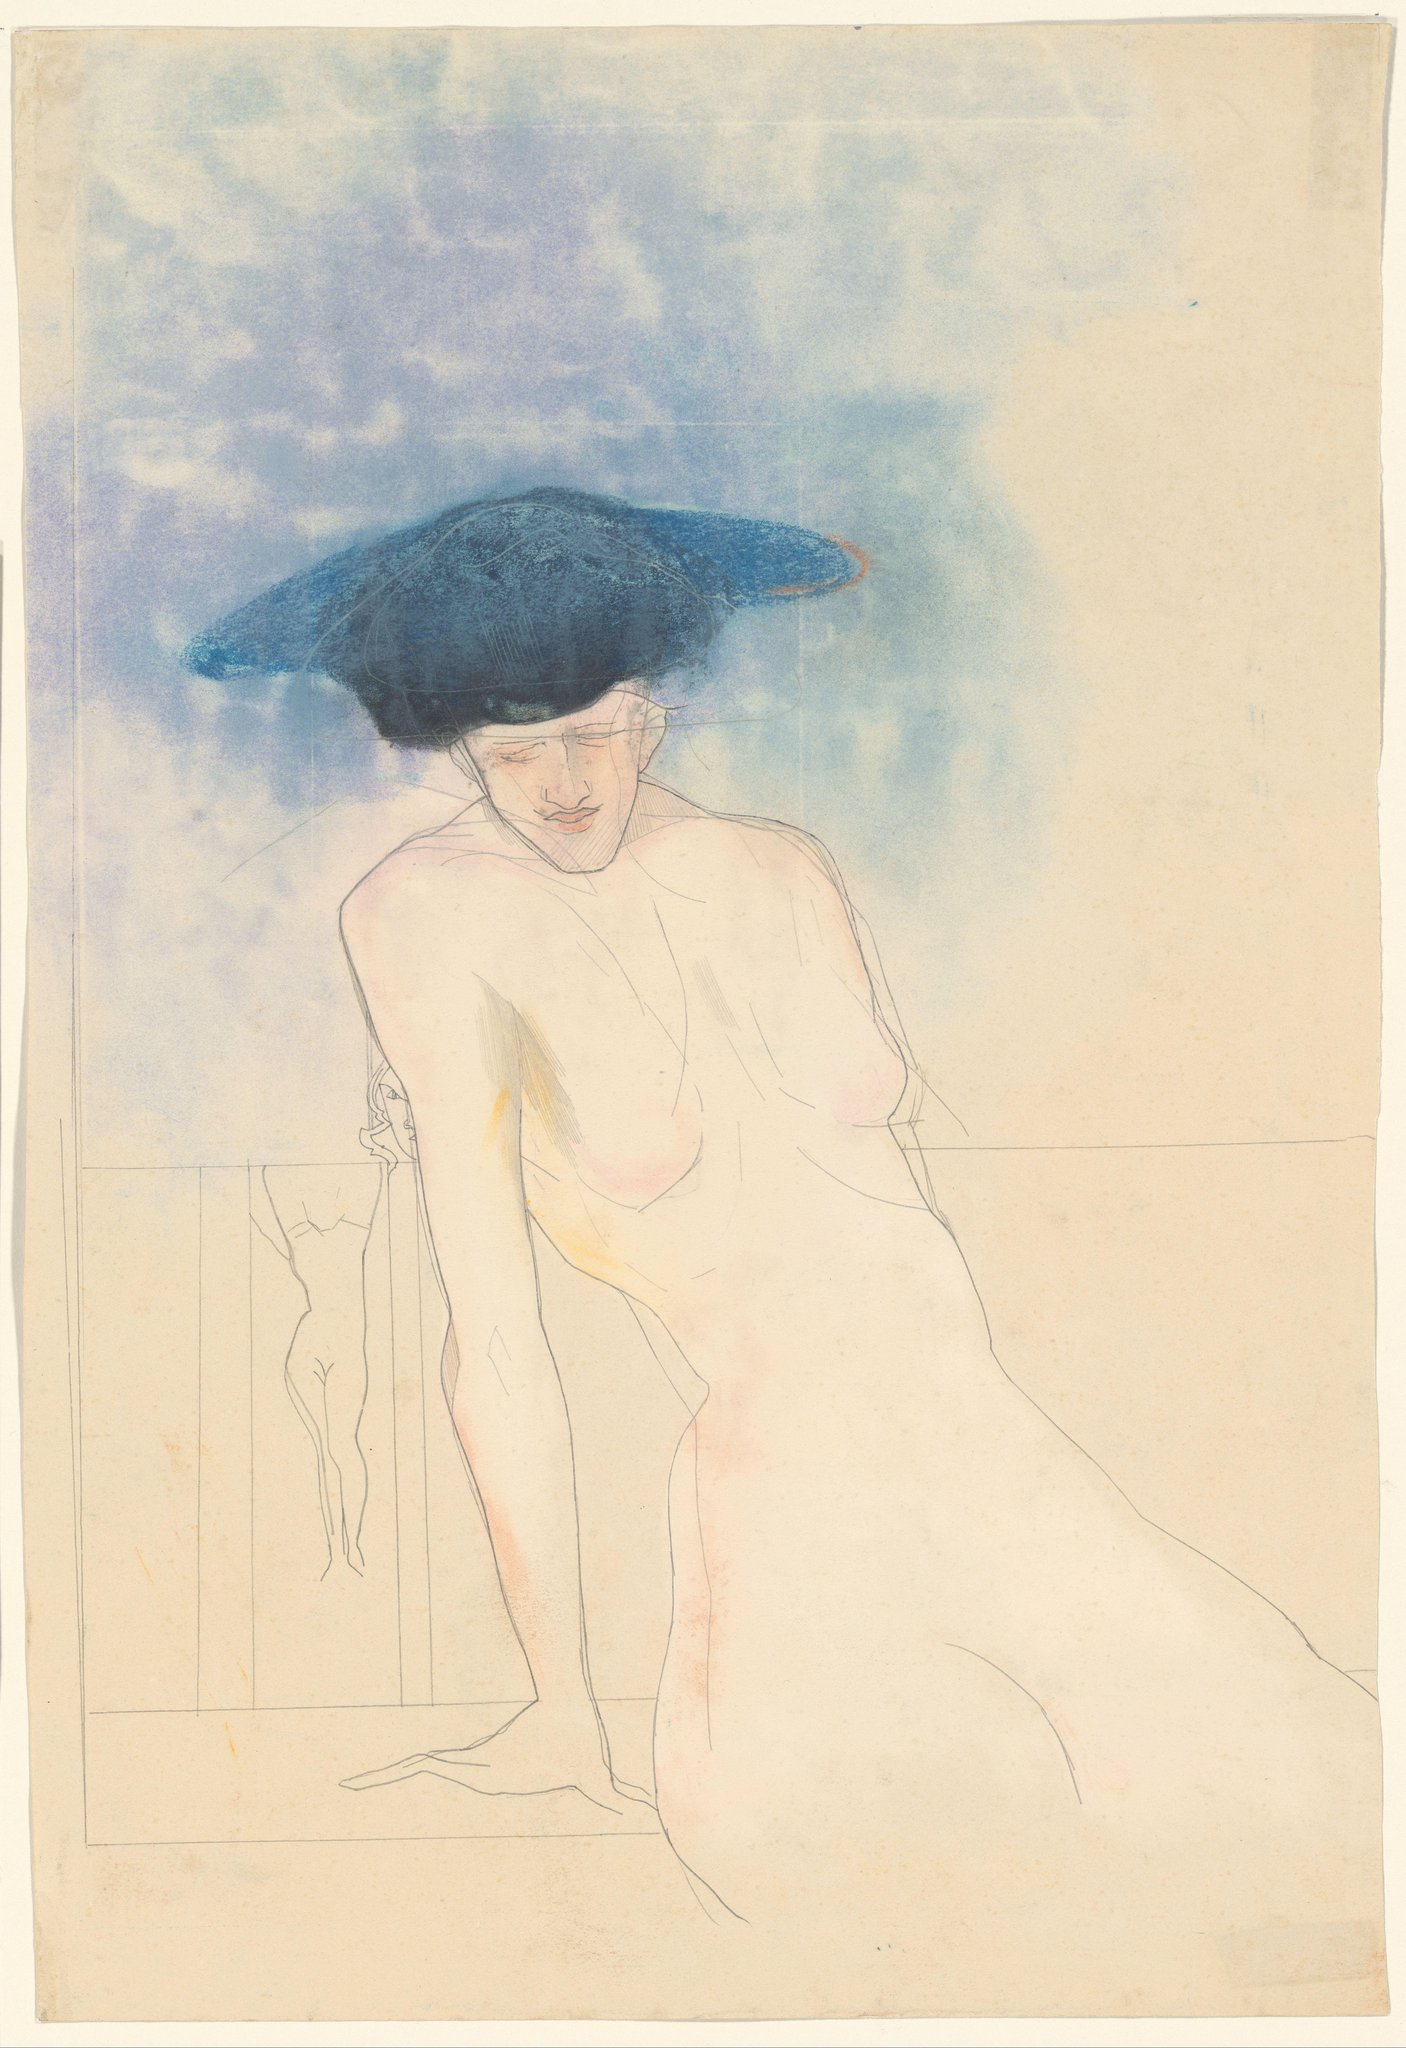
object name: drawing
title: Zittende figuur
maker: karel de nerée tot babberich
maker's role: draughtsman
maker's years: 1880-1909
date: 1905-1907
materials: chalk, paint, paper, pencil, watercolor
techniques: drawing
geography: switzerland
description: Een zittende, androgyne figuur met masculiene gelaatstrekken en een vrouwenlichaam. De figuur is naakt en draagt een hoed. Ter hoogte van de rechteroksel bevindt zich het gezicht van een vrouw, mogelijk een masker. Daaronder is op schetsmatige wijze een staande figuur met opgeheven armen afgebeeld.